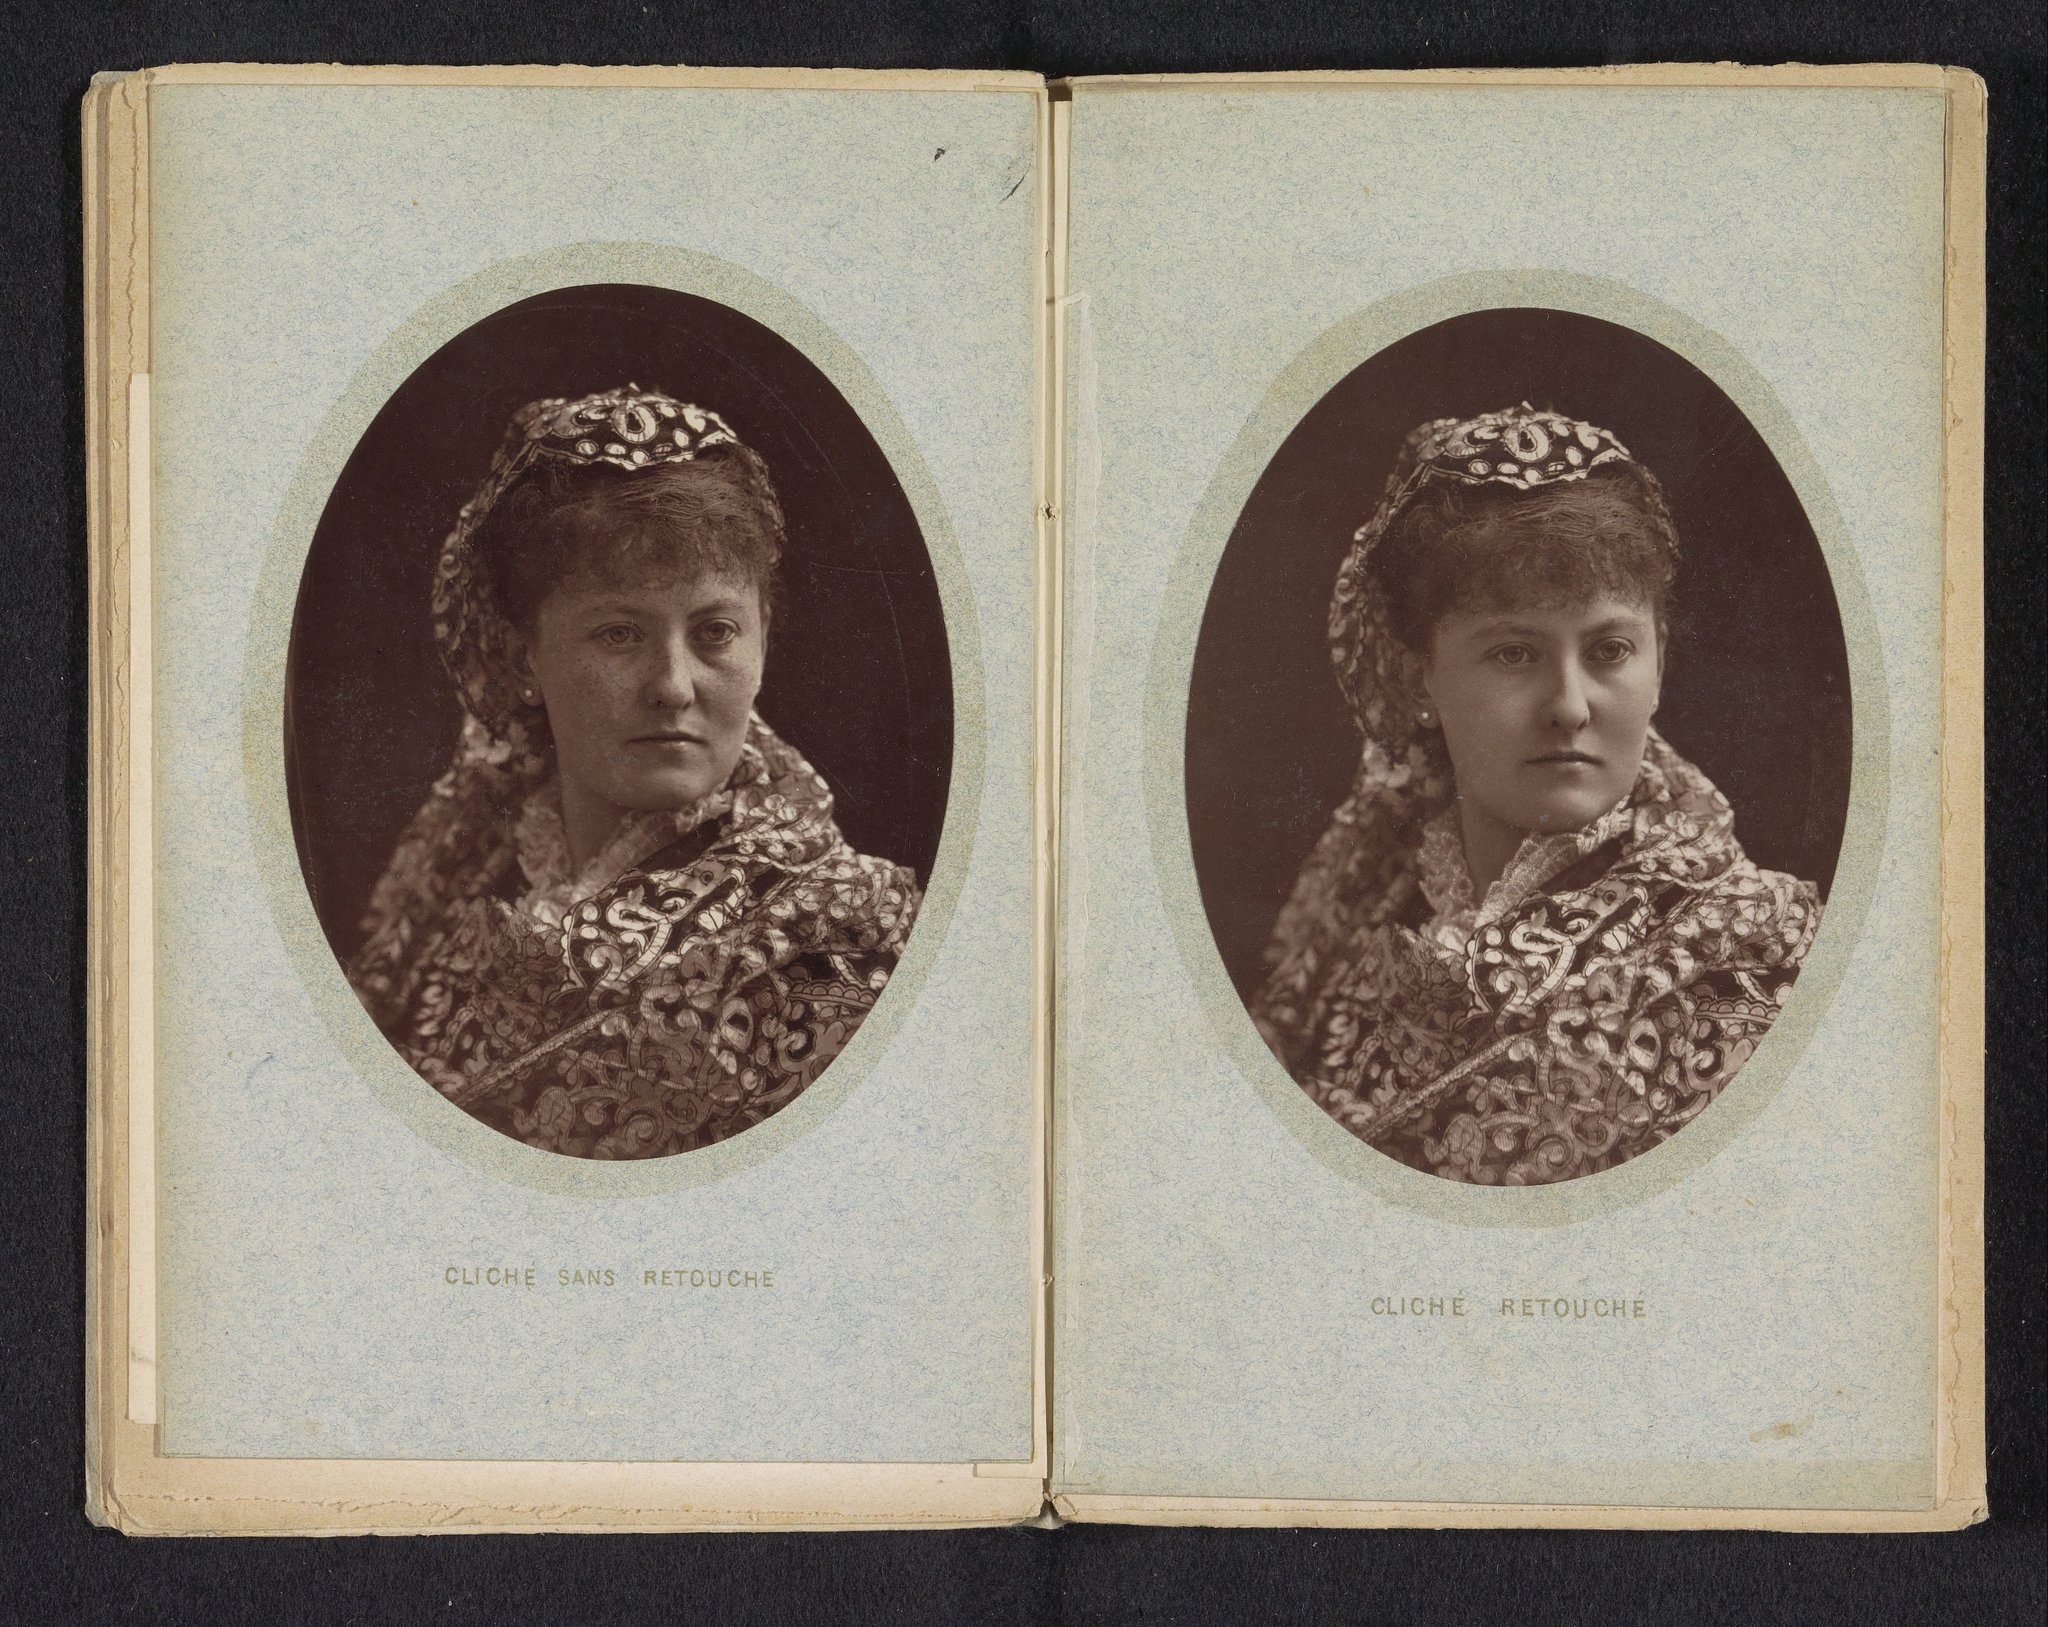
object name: page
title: Cliché retouché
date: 1871-1881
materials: paper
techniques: woodburytype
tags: historical persons not known by name - bb - woman (+ (full) bust portrait)